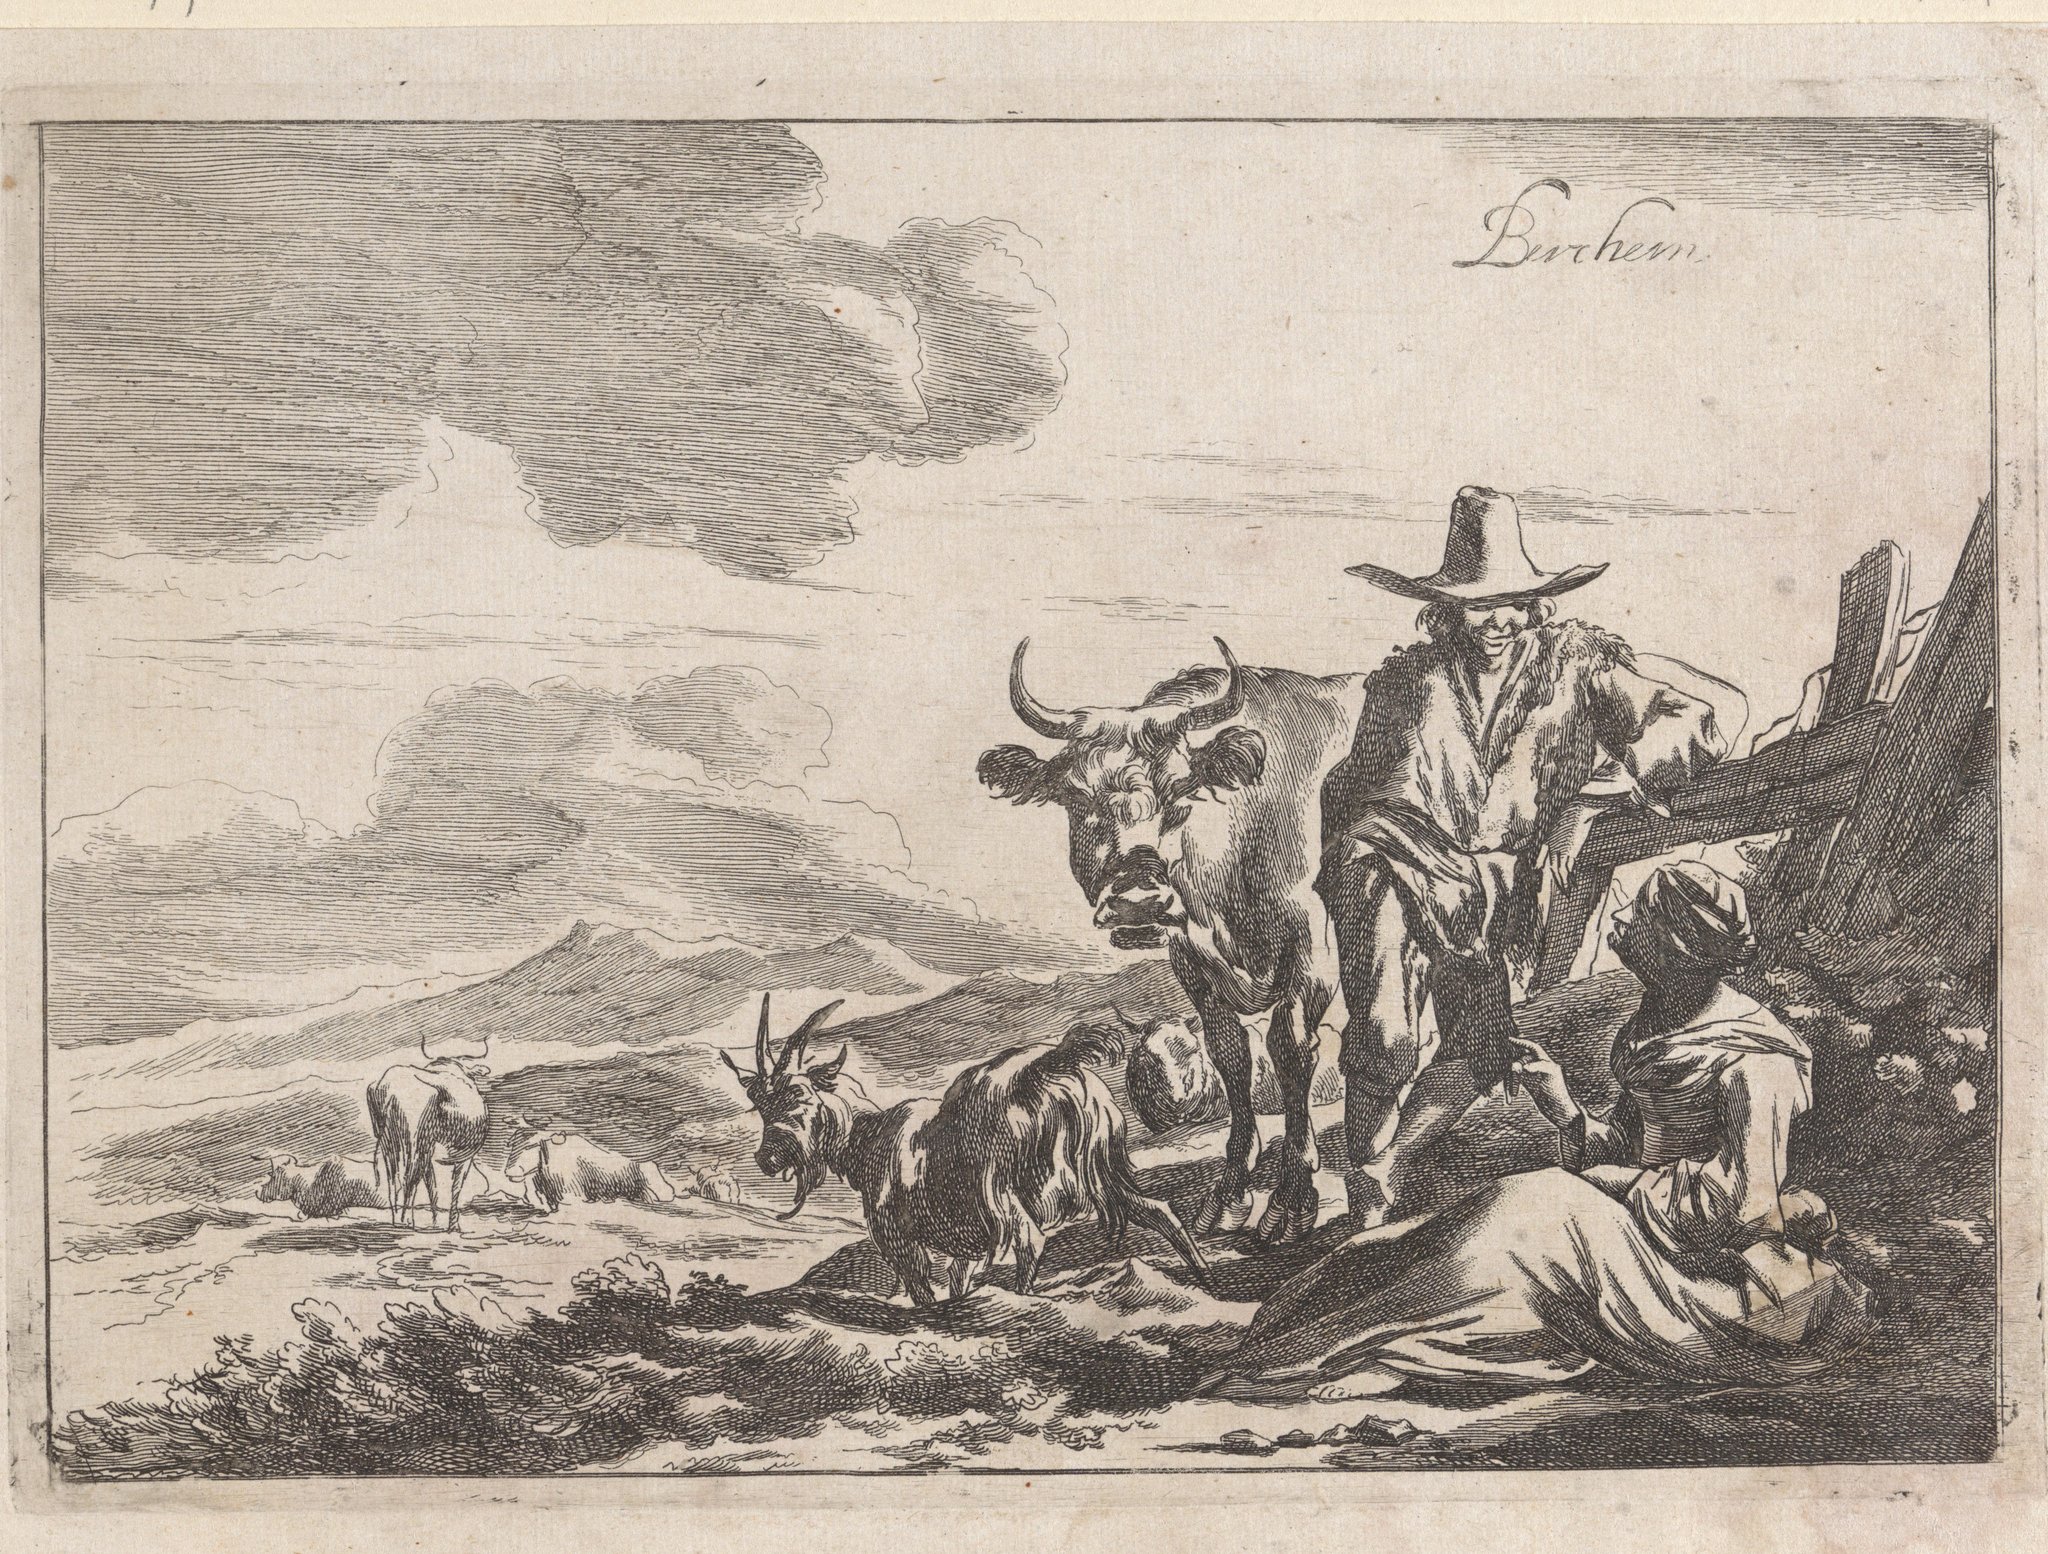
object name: print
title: Herder in gesprek met een zittende vrouw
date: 1643-1701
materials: paper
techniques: etching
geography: northern netherlands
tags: cow, landscapes, herding, herdsman, herdswoman, shepherd, shepherdess, cowherd, etc., conversation, dialogue; conversation piece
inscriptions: collector's mark: Lugt 240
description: Bij een halfhoog hek voert een herder een gesprek met een zittende vrouw. Op de achtergrond staan koeien en geiten en zijn heuvels te zien.